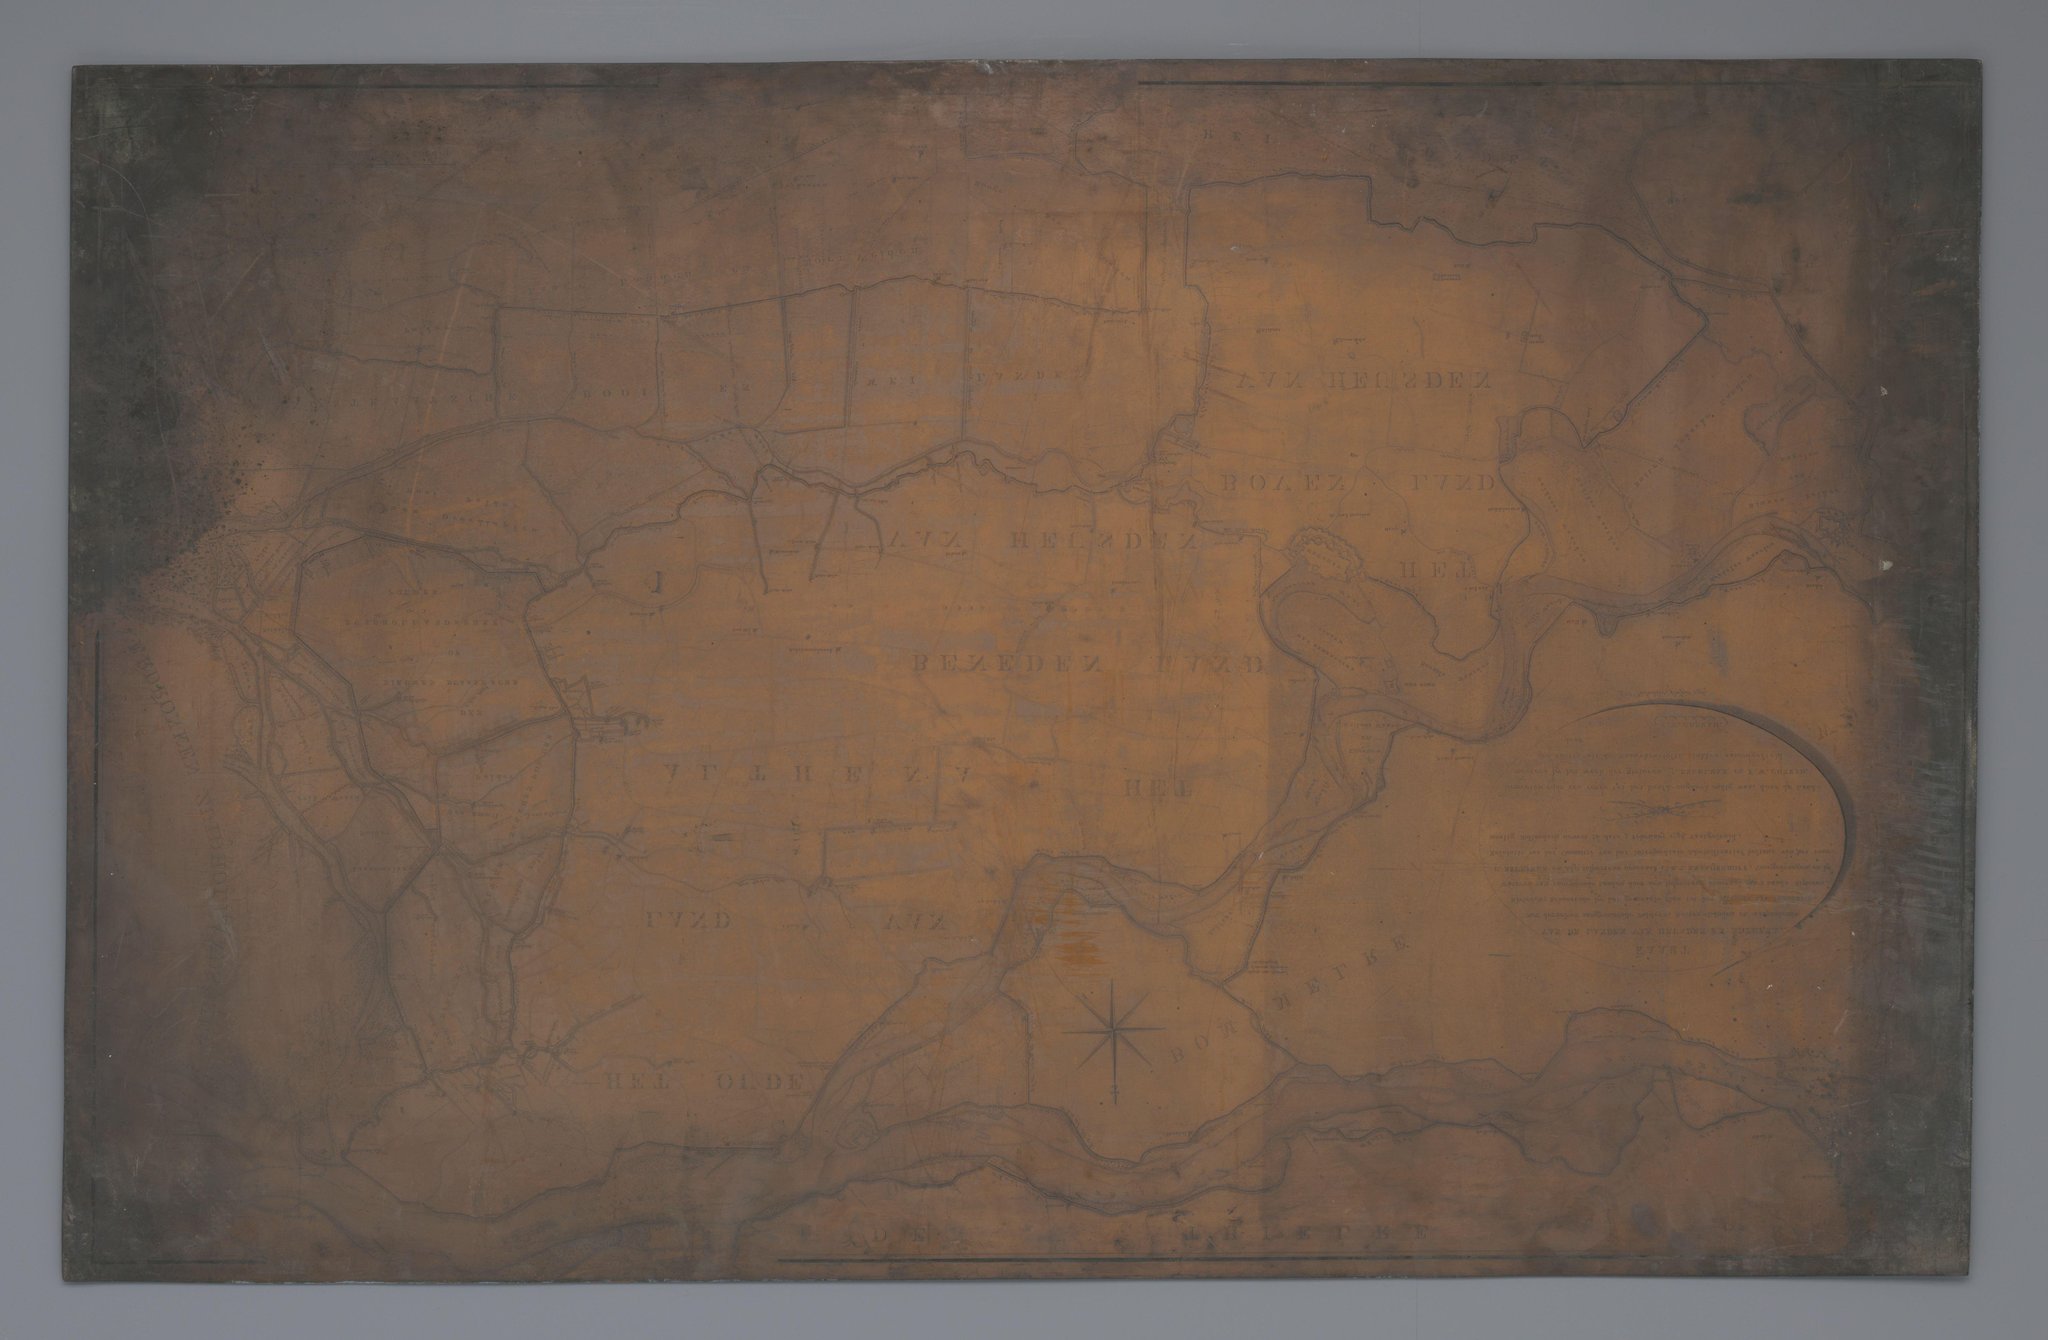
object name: copper plate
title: Koperplaat met een kaart van de Landen van Heusden en Altena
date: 1798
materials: copper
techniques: engraving